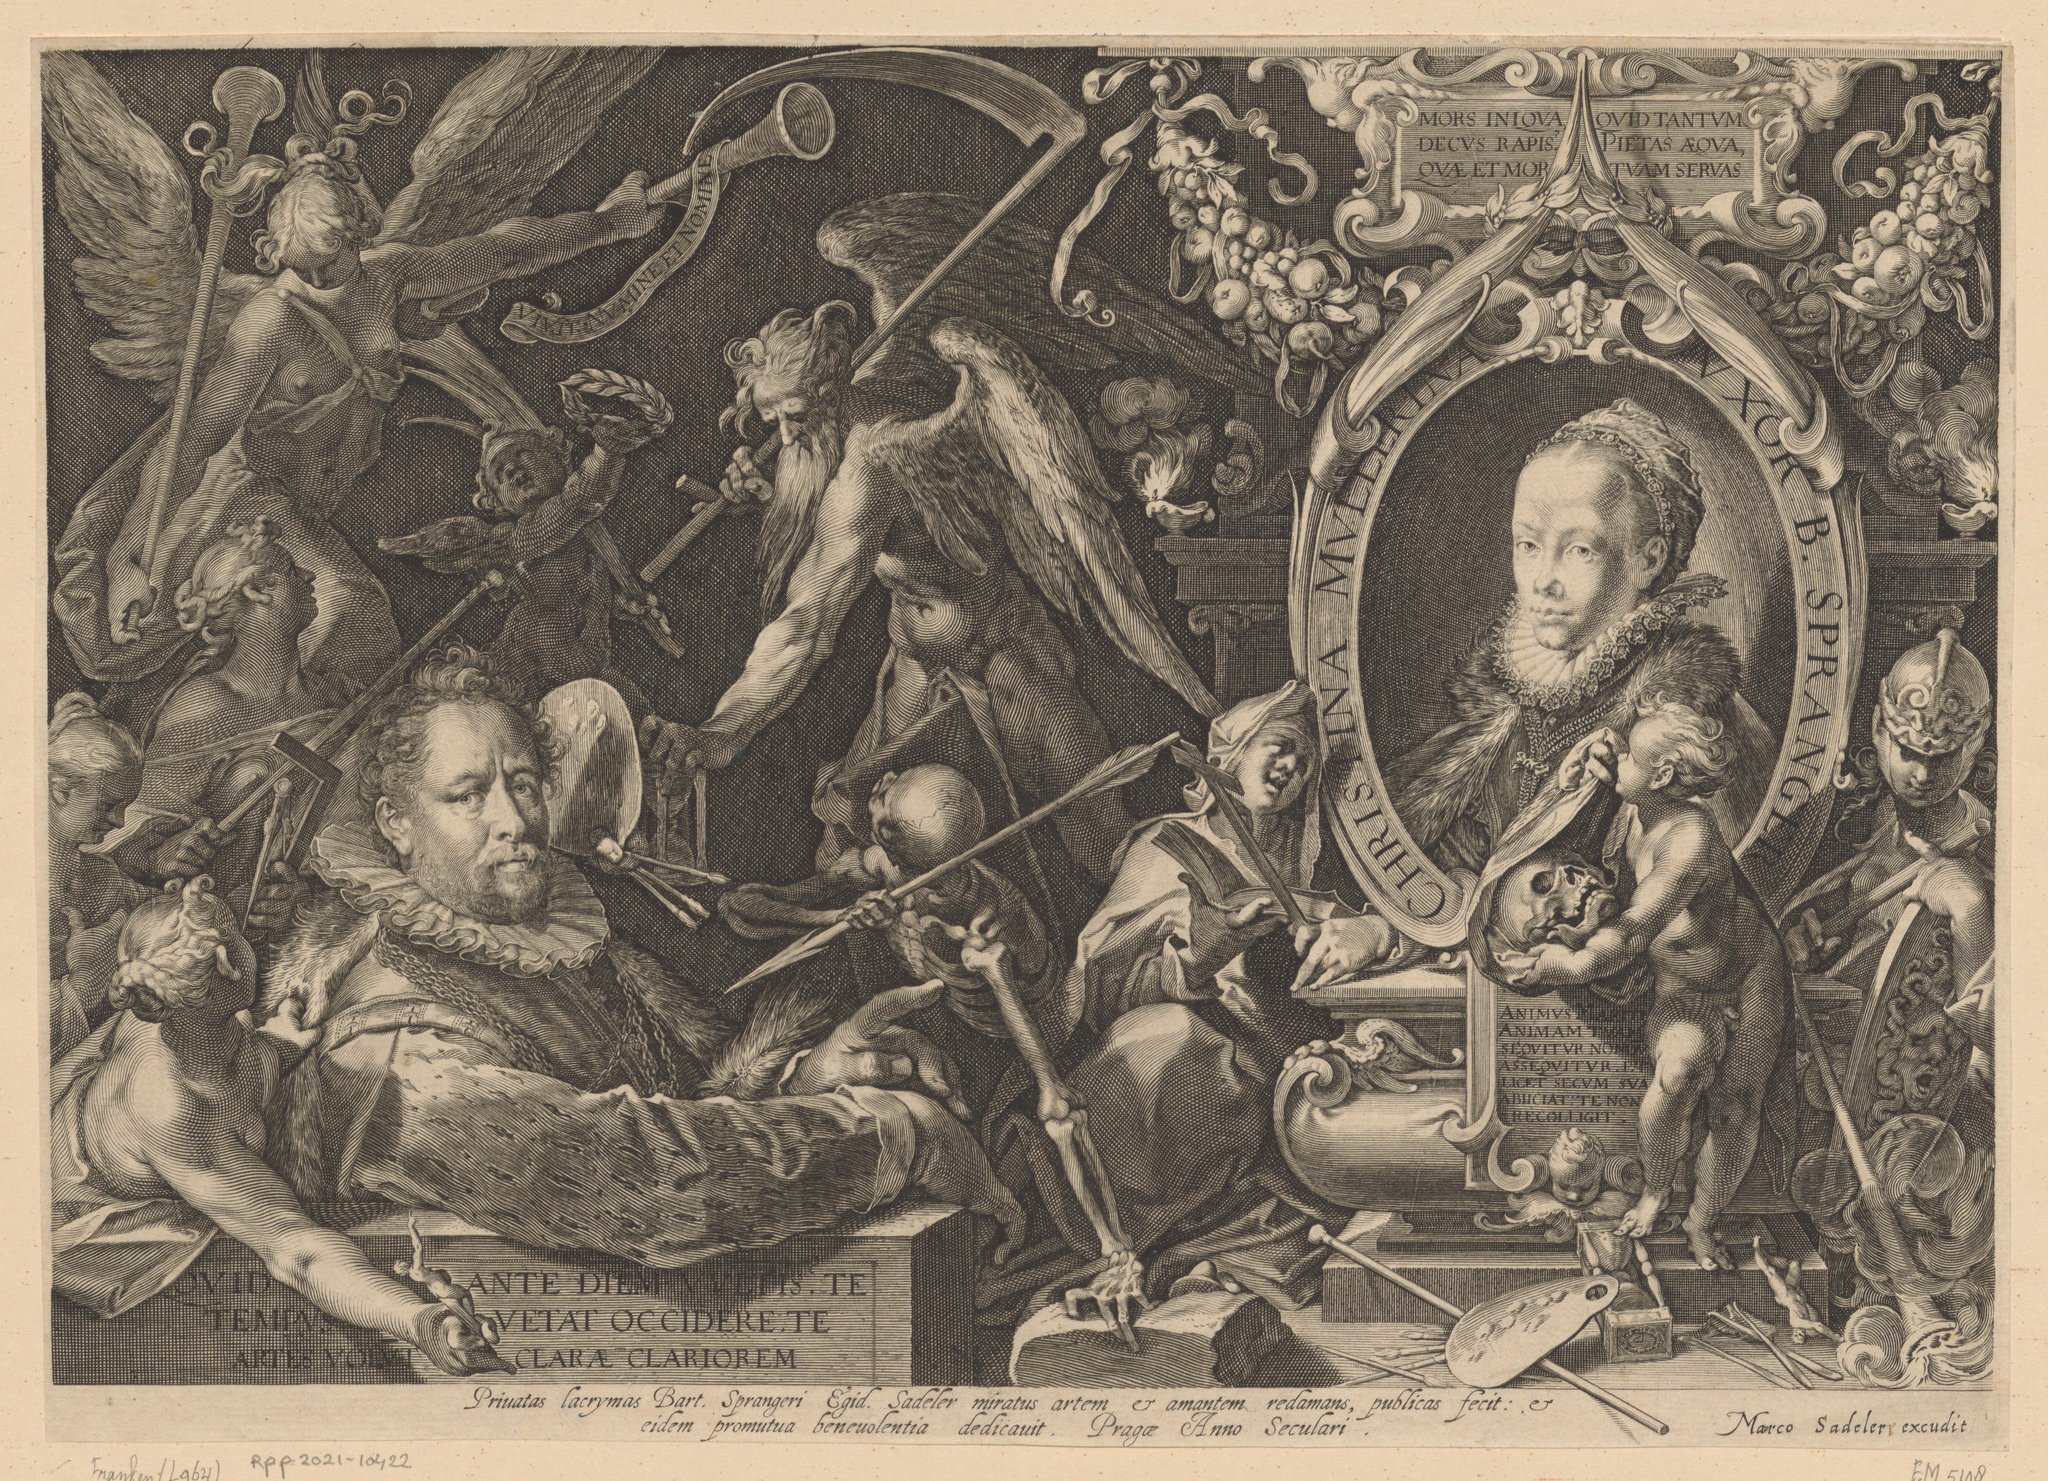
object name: print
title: Allegorisch portret van Bartholomeus Spranger en zijn vrouw Christina Muller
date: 1600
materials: paper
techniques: engraving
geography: prague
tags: prague, print maker, draughtsman, bartholomeus spranger, faith, 'fides'; 'fede', 'fede catholica', 'fede christiana', 'fede christiana catholica' (ripa) ~ one of the three theological virtues, (story of) minerva (pallas, athena), death as skeleton, historical persons, tools, implements of painter, fame; 'fama', 'fama buona', 'fama chiara' (ripa), ornament ~ festoon, garland, father time, man with wings and scythe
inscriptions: collector's mark: Lugt 964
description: Gedenkprent voor de overleden vrouw van de schilder Bartholomeus Spranger. Links Bartholomeus Spranger en rechts zijn vrouw Christina Muller. De twee portretten worden omringd door de personificaties van de vrije kunsten, het geloof, de tijd, de dood en de roem.